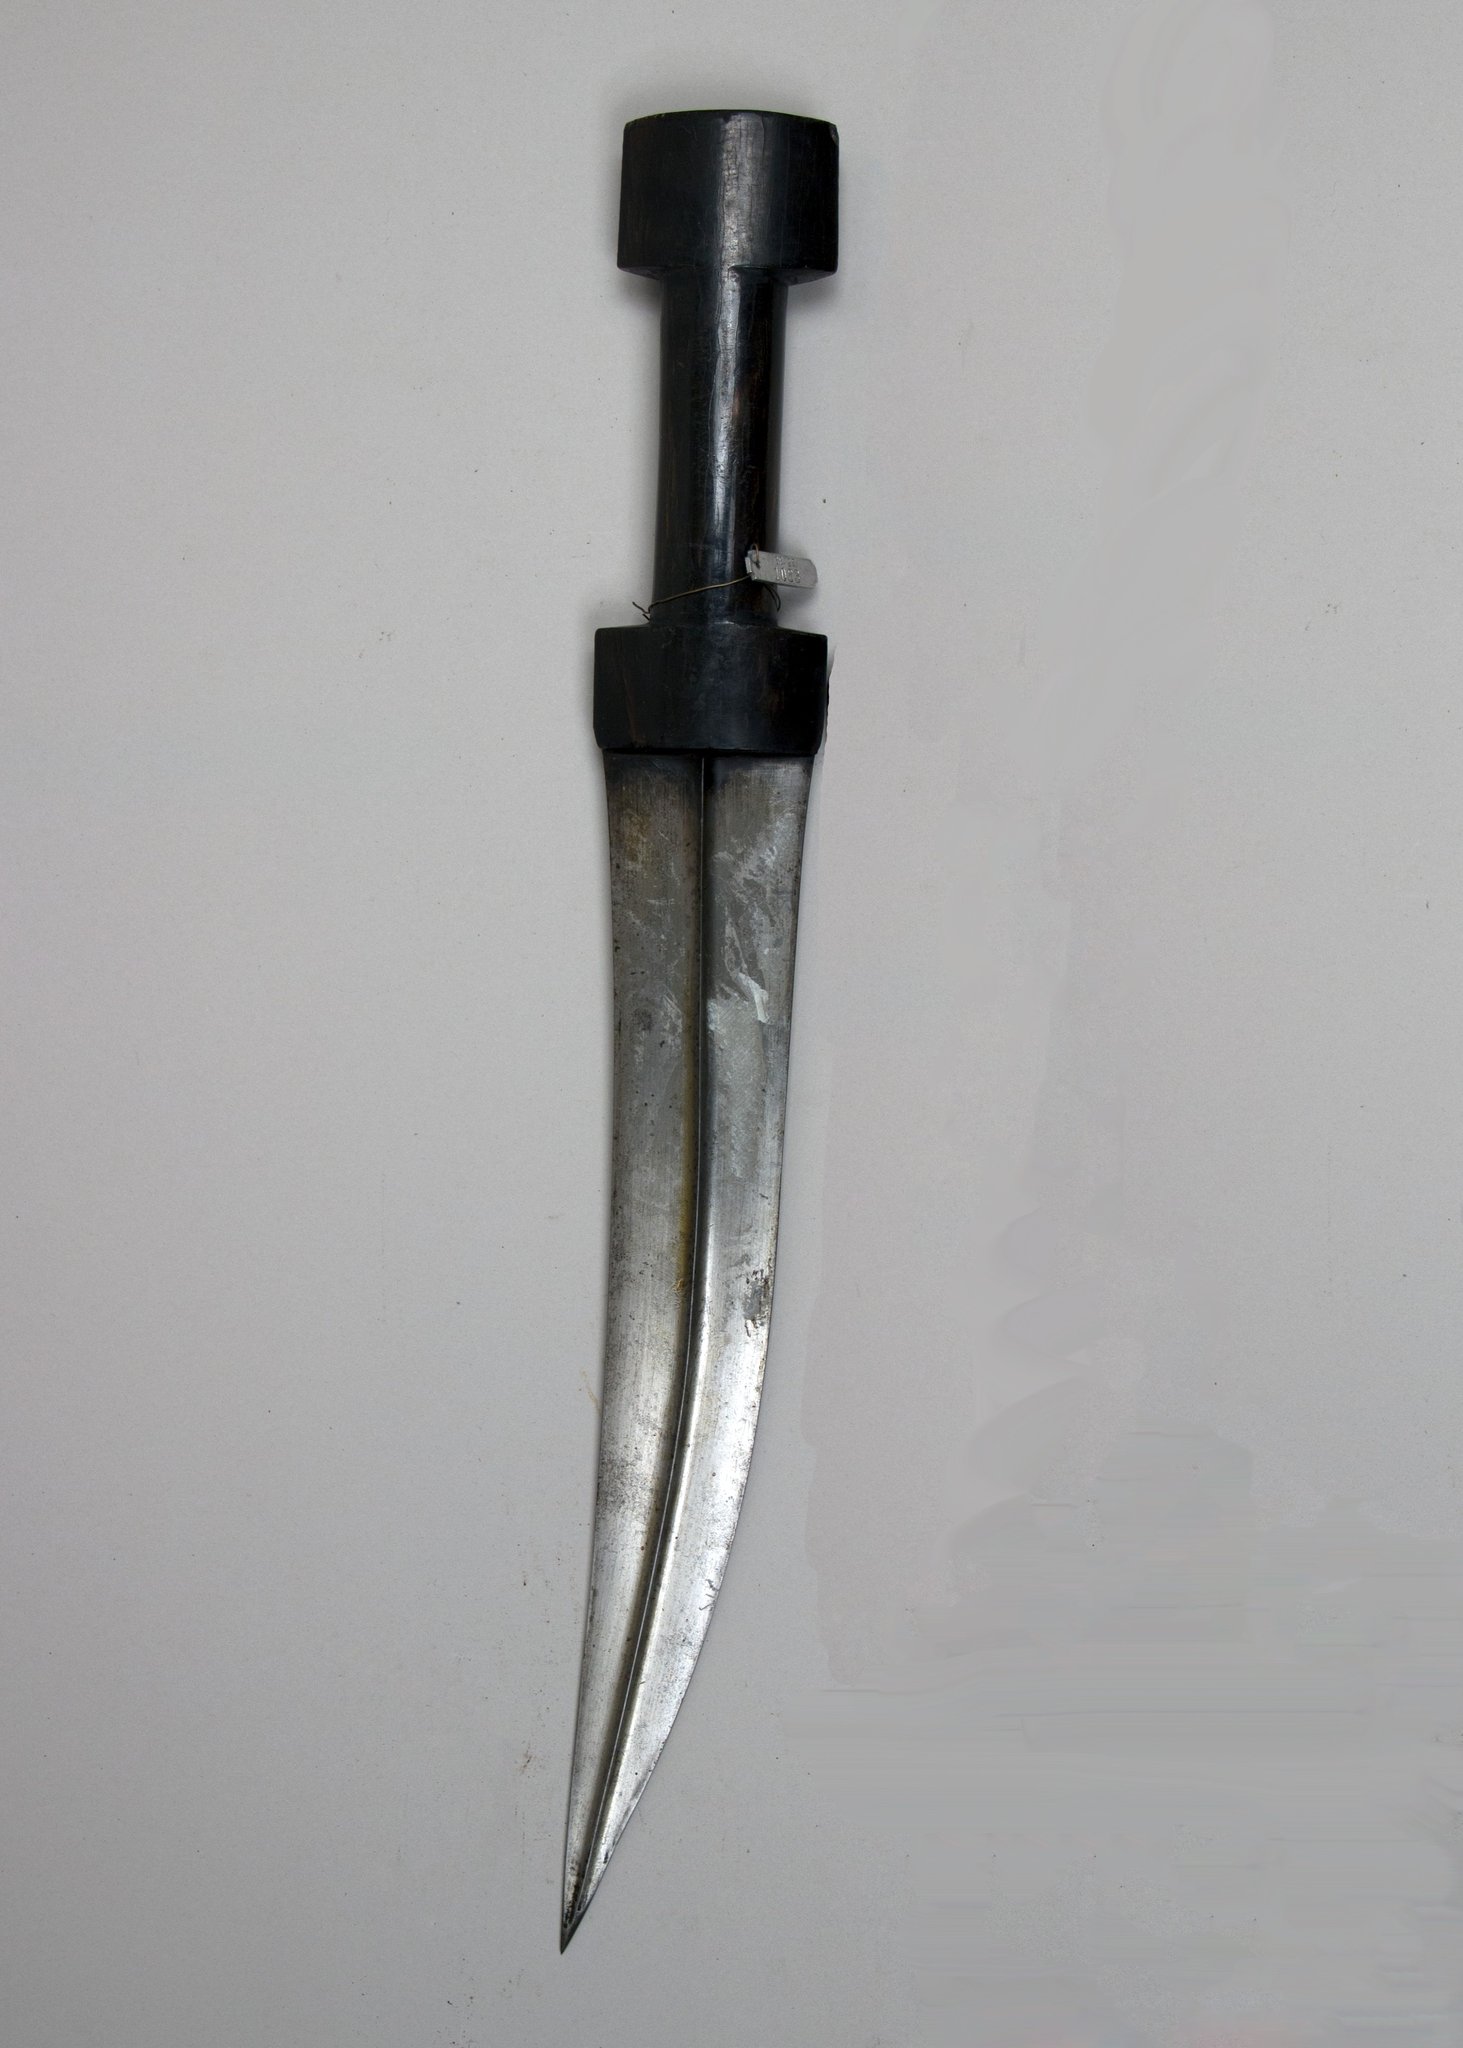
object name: dagger jambiya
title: Dagger (Jambiya)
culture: persian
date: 1801-1900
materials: horn, steel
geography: iran